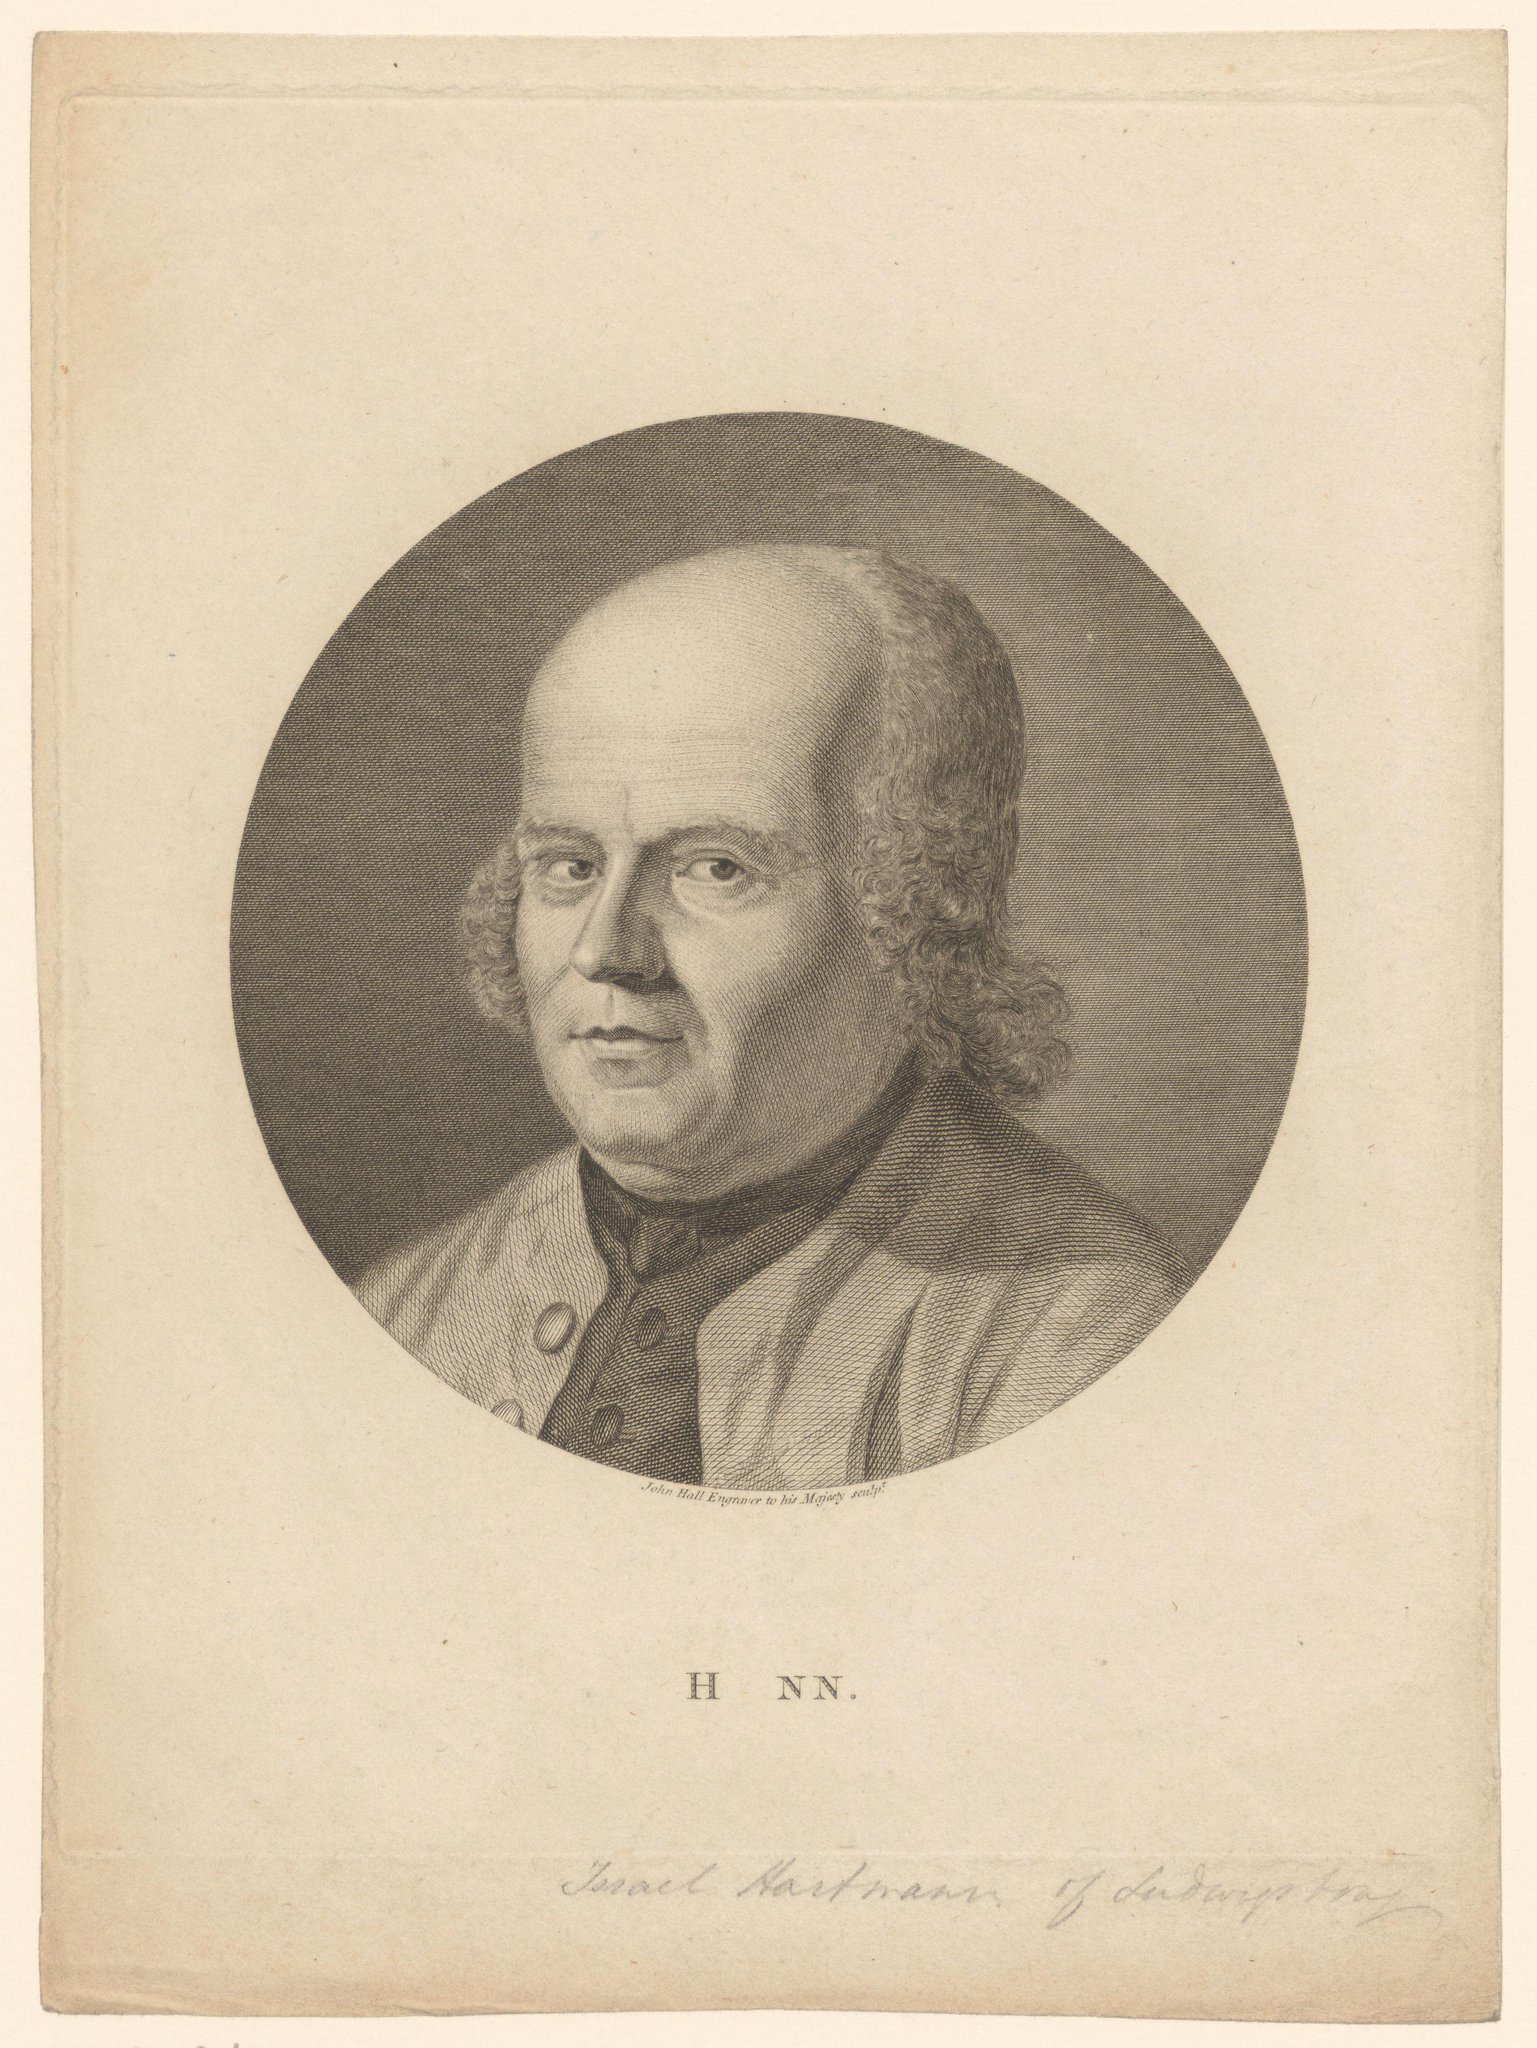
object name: print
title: Portret van Israel Hartmann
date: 1765-1797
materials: paper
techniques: etching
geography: great britain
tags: historical persons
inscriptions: collector's mark: Lugt 2233